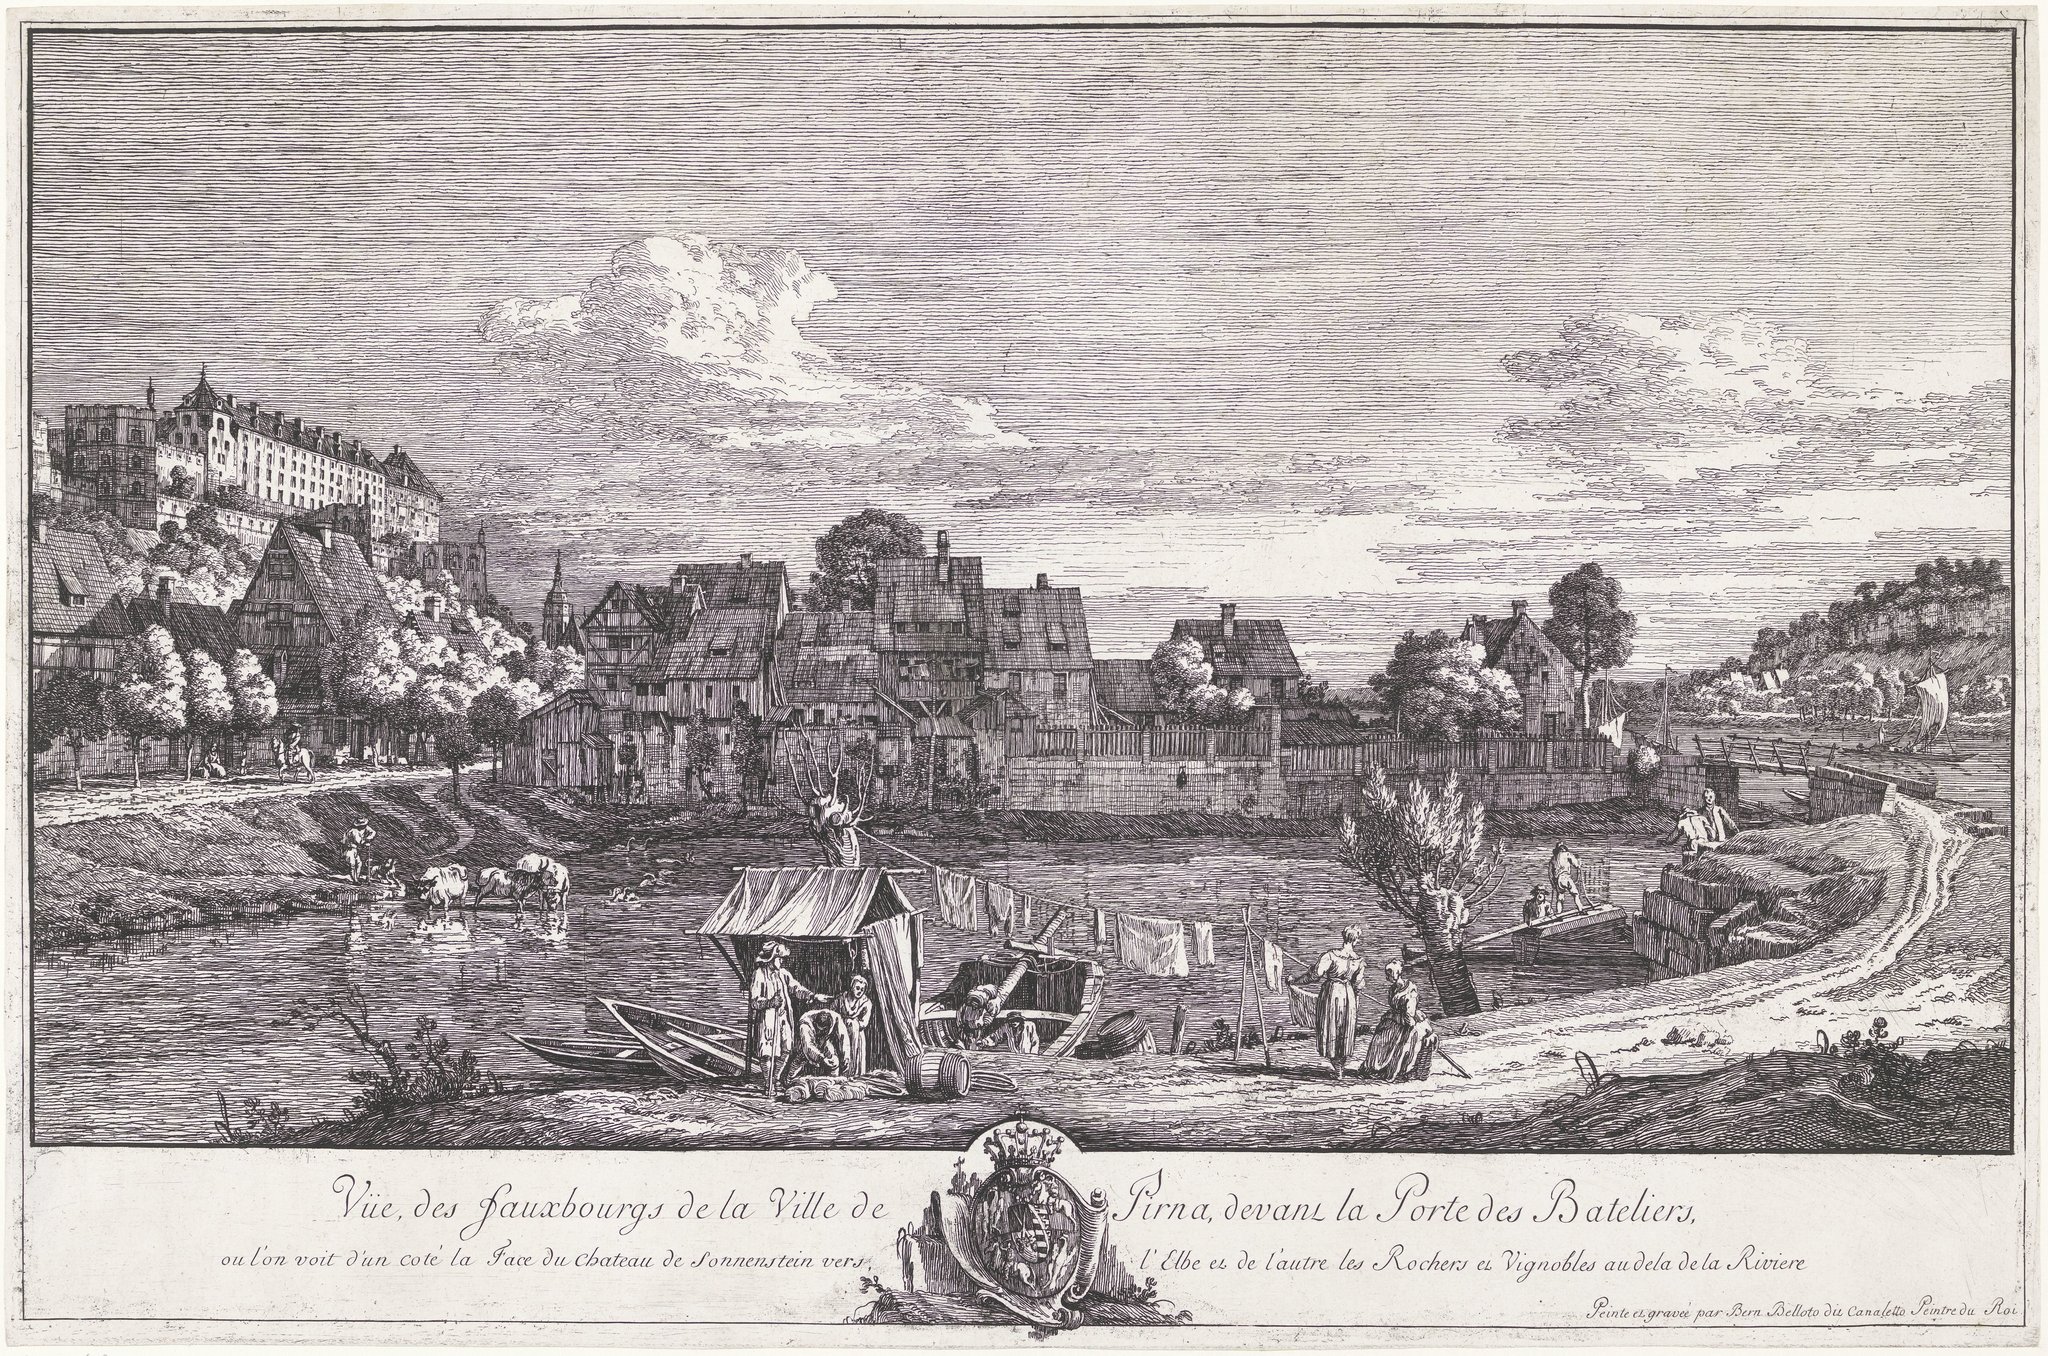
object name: print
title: Gezicht op de buitenwijk van Pirna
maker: bernardo bellotto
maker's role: draughtsman, painter, print maker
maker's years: 1721-1780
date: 1730-1780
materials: paper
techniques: etching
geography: germany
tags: castle, outskirts of village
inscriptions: collector's mark: Lugt 2228, collector's mark: Lugt 2760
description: Op de voorgrond vrouwen die de was doen. Schloss Sonnenstein op de achtergrond links. Tekst en wapenschild in ondermarge.